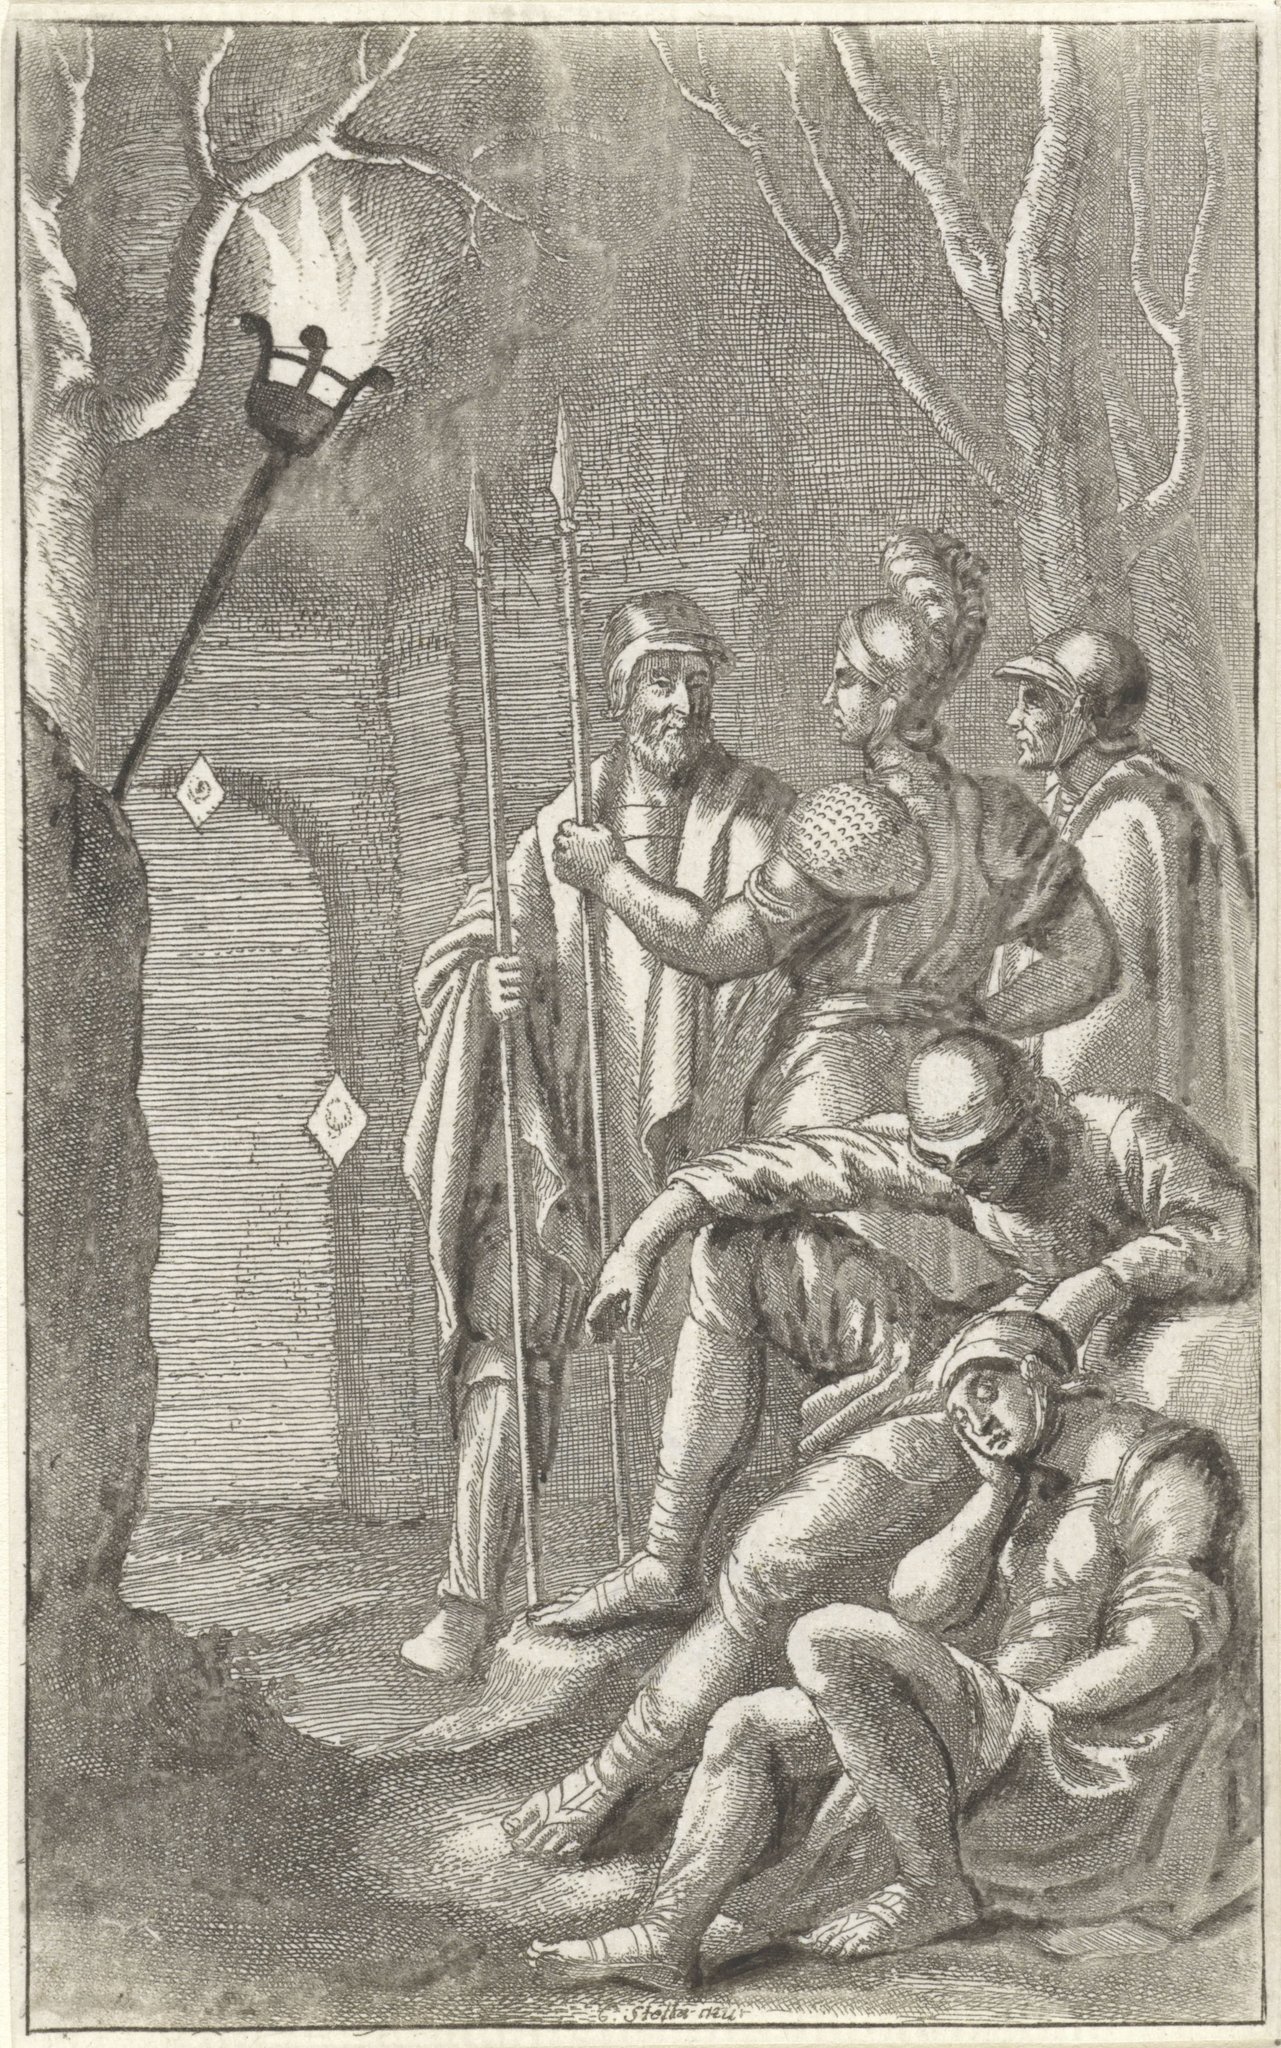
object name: print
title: Wachters bij graf van Christus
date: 1670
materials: paper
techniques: etching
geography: london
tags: sleeping soldiers at the tomb of christ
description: Prent opgenomen in: The Office Of The Holy Week According To The Missall And Roman Breviary. Printed by the Widow Chrestien, 1670, naast p. 367. Prent tevens opgenomen in latere uitgave: The Compleat Office of the Holy Week. Londen: Matthew Turner, 1687.